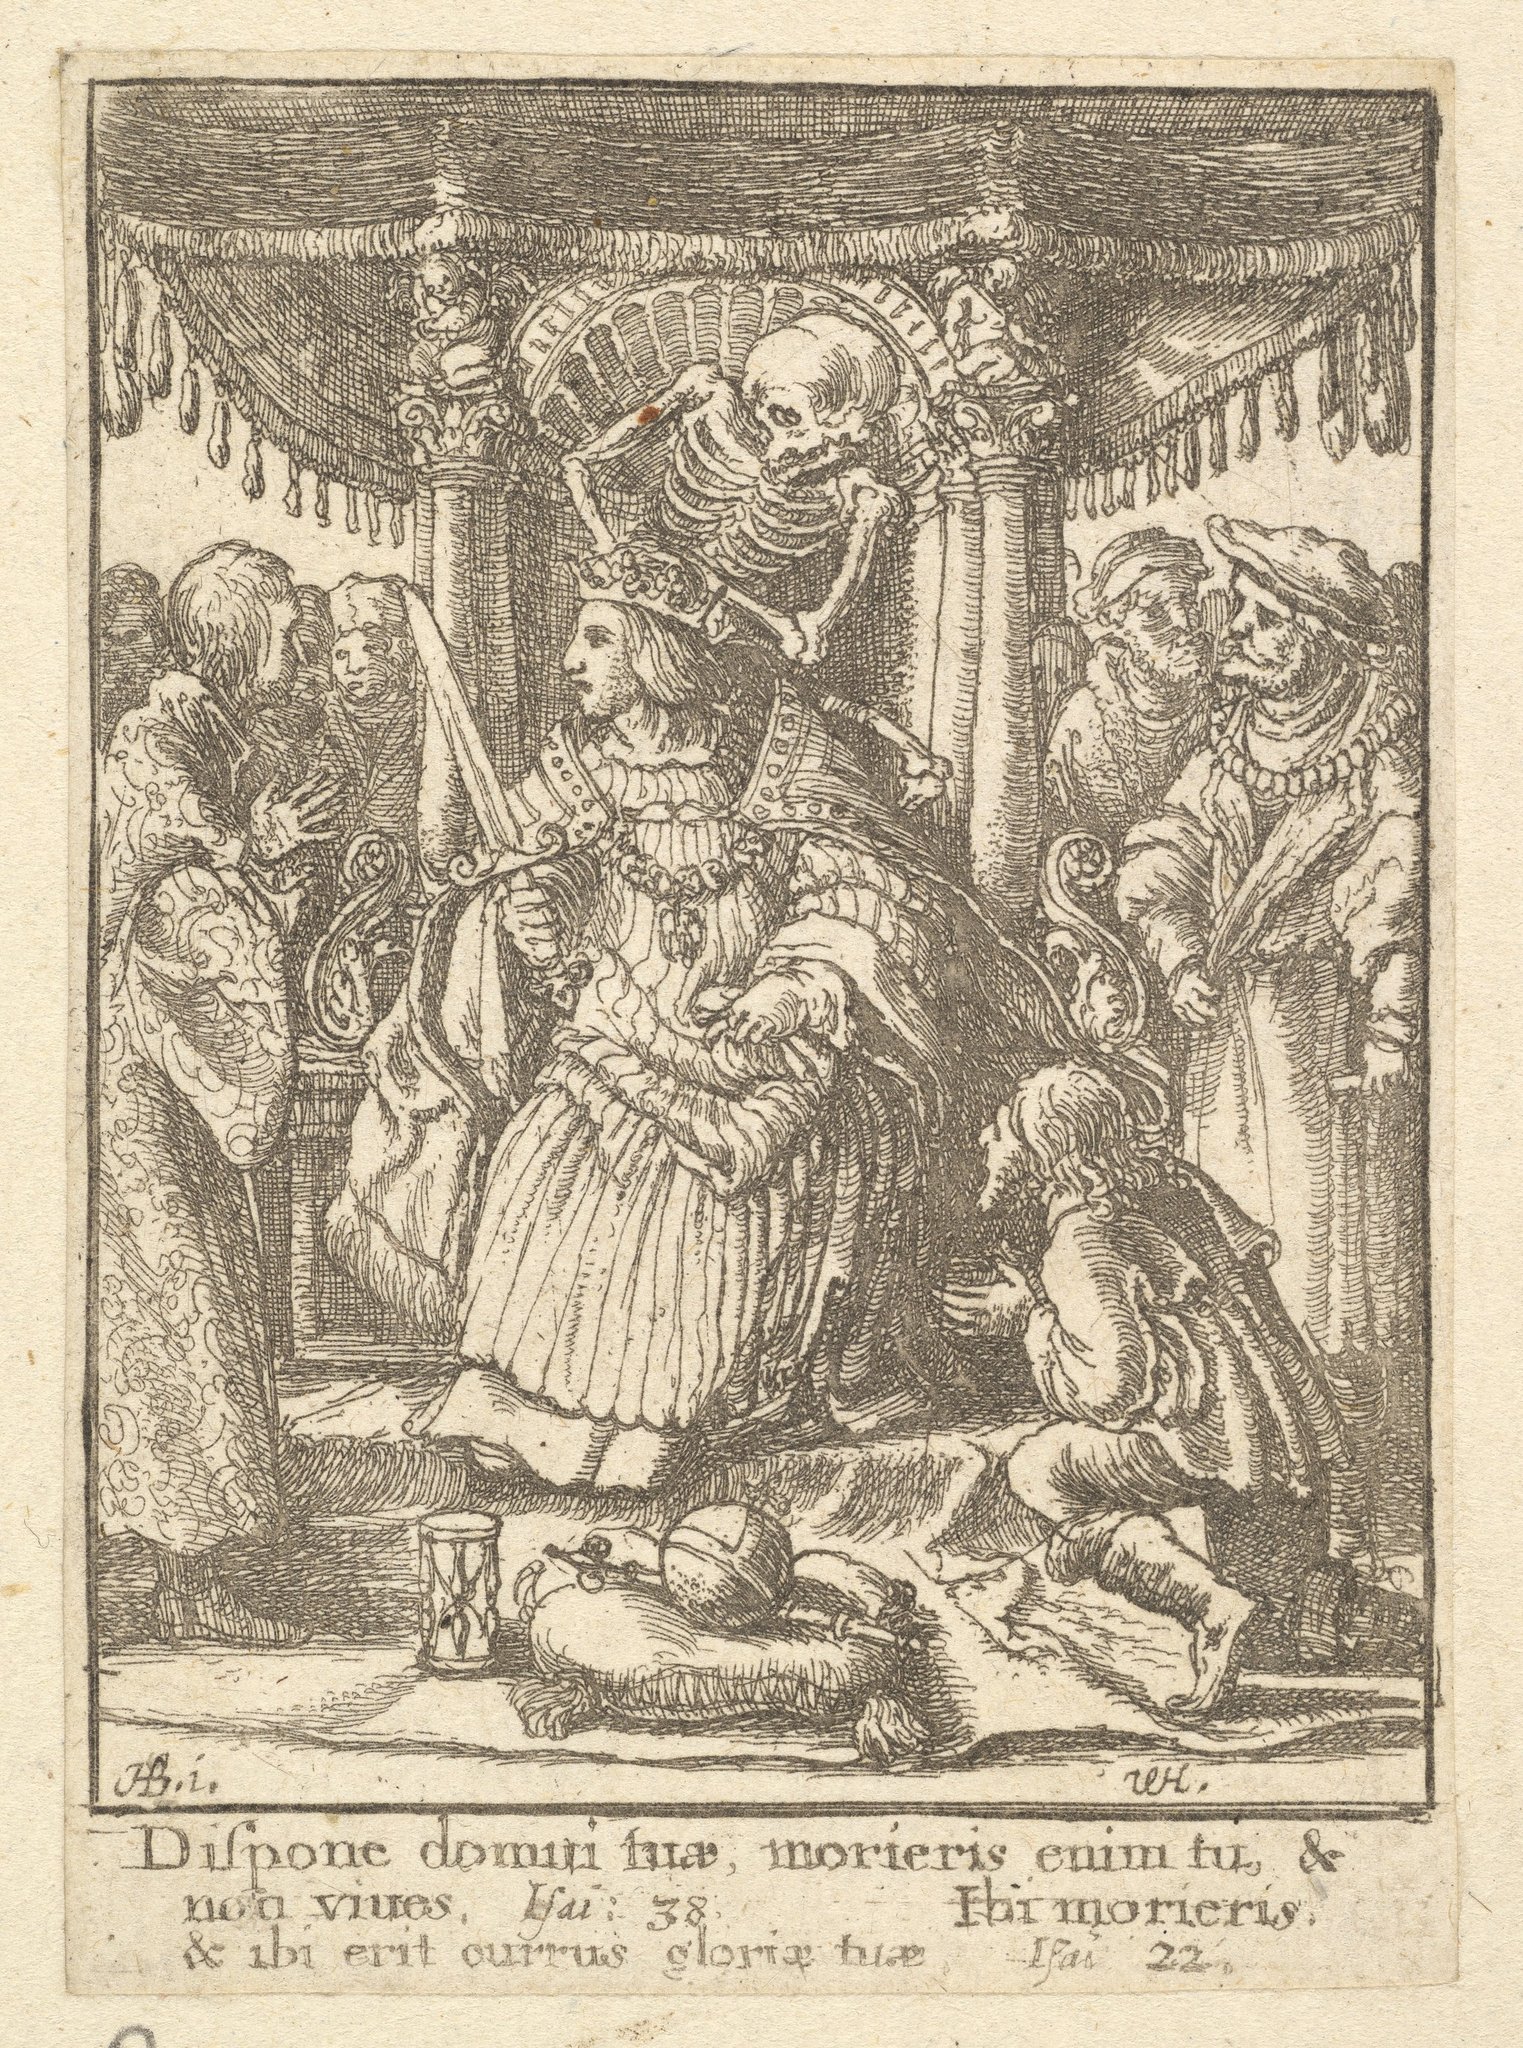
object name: print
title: The Emperor, from the Dance of Death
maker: wenceslaus hollar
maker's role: artist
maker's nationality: bohemian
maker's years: 1607-1677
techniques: etching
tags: weapons,skeletons,men